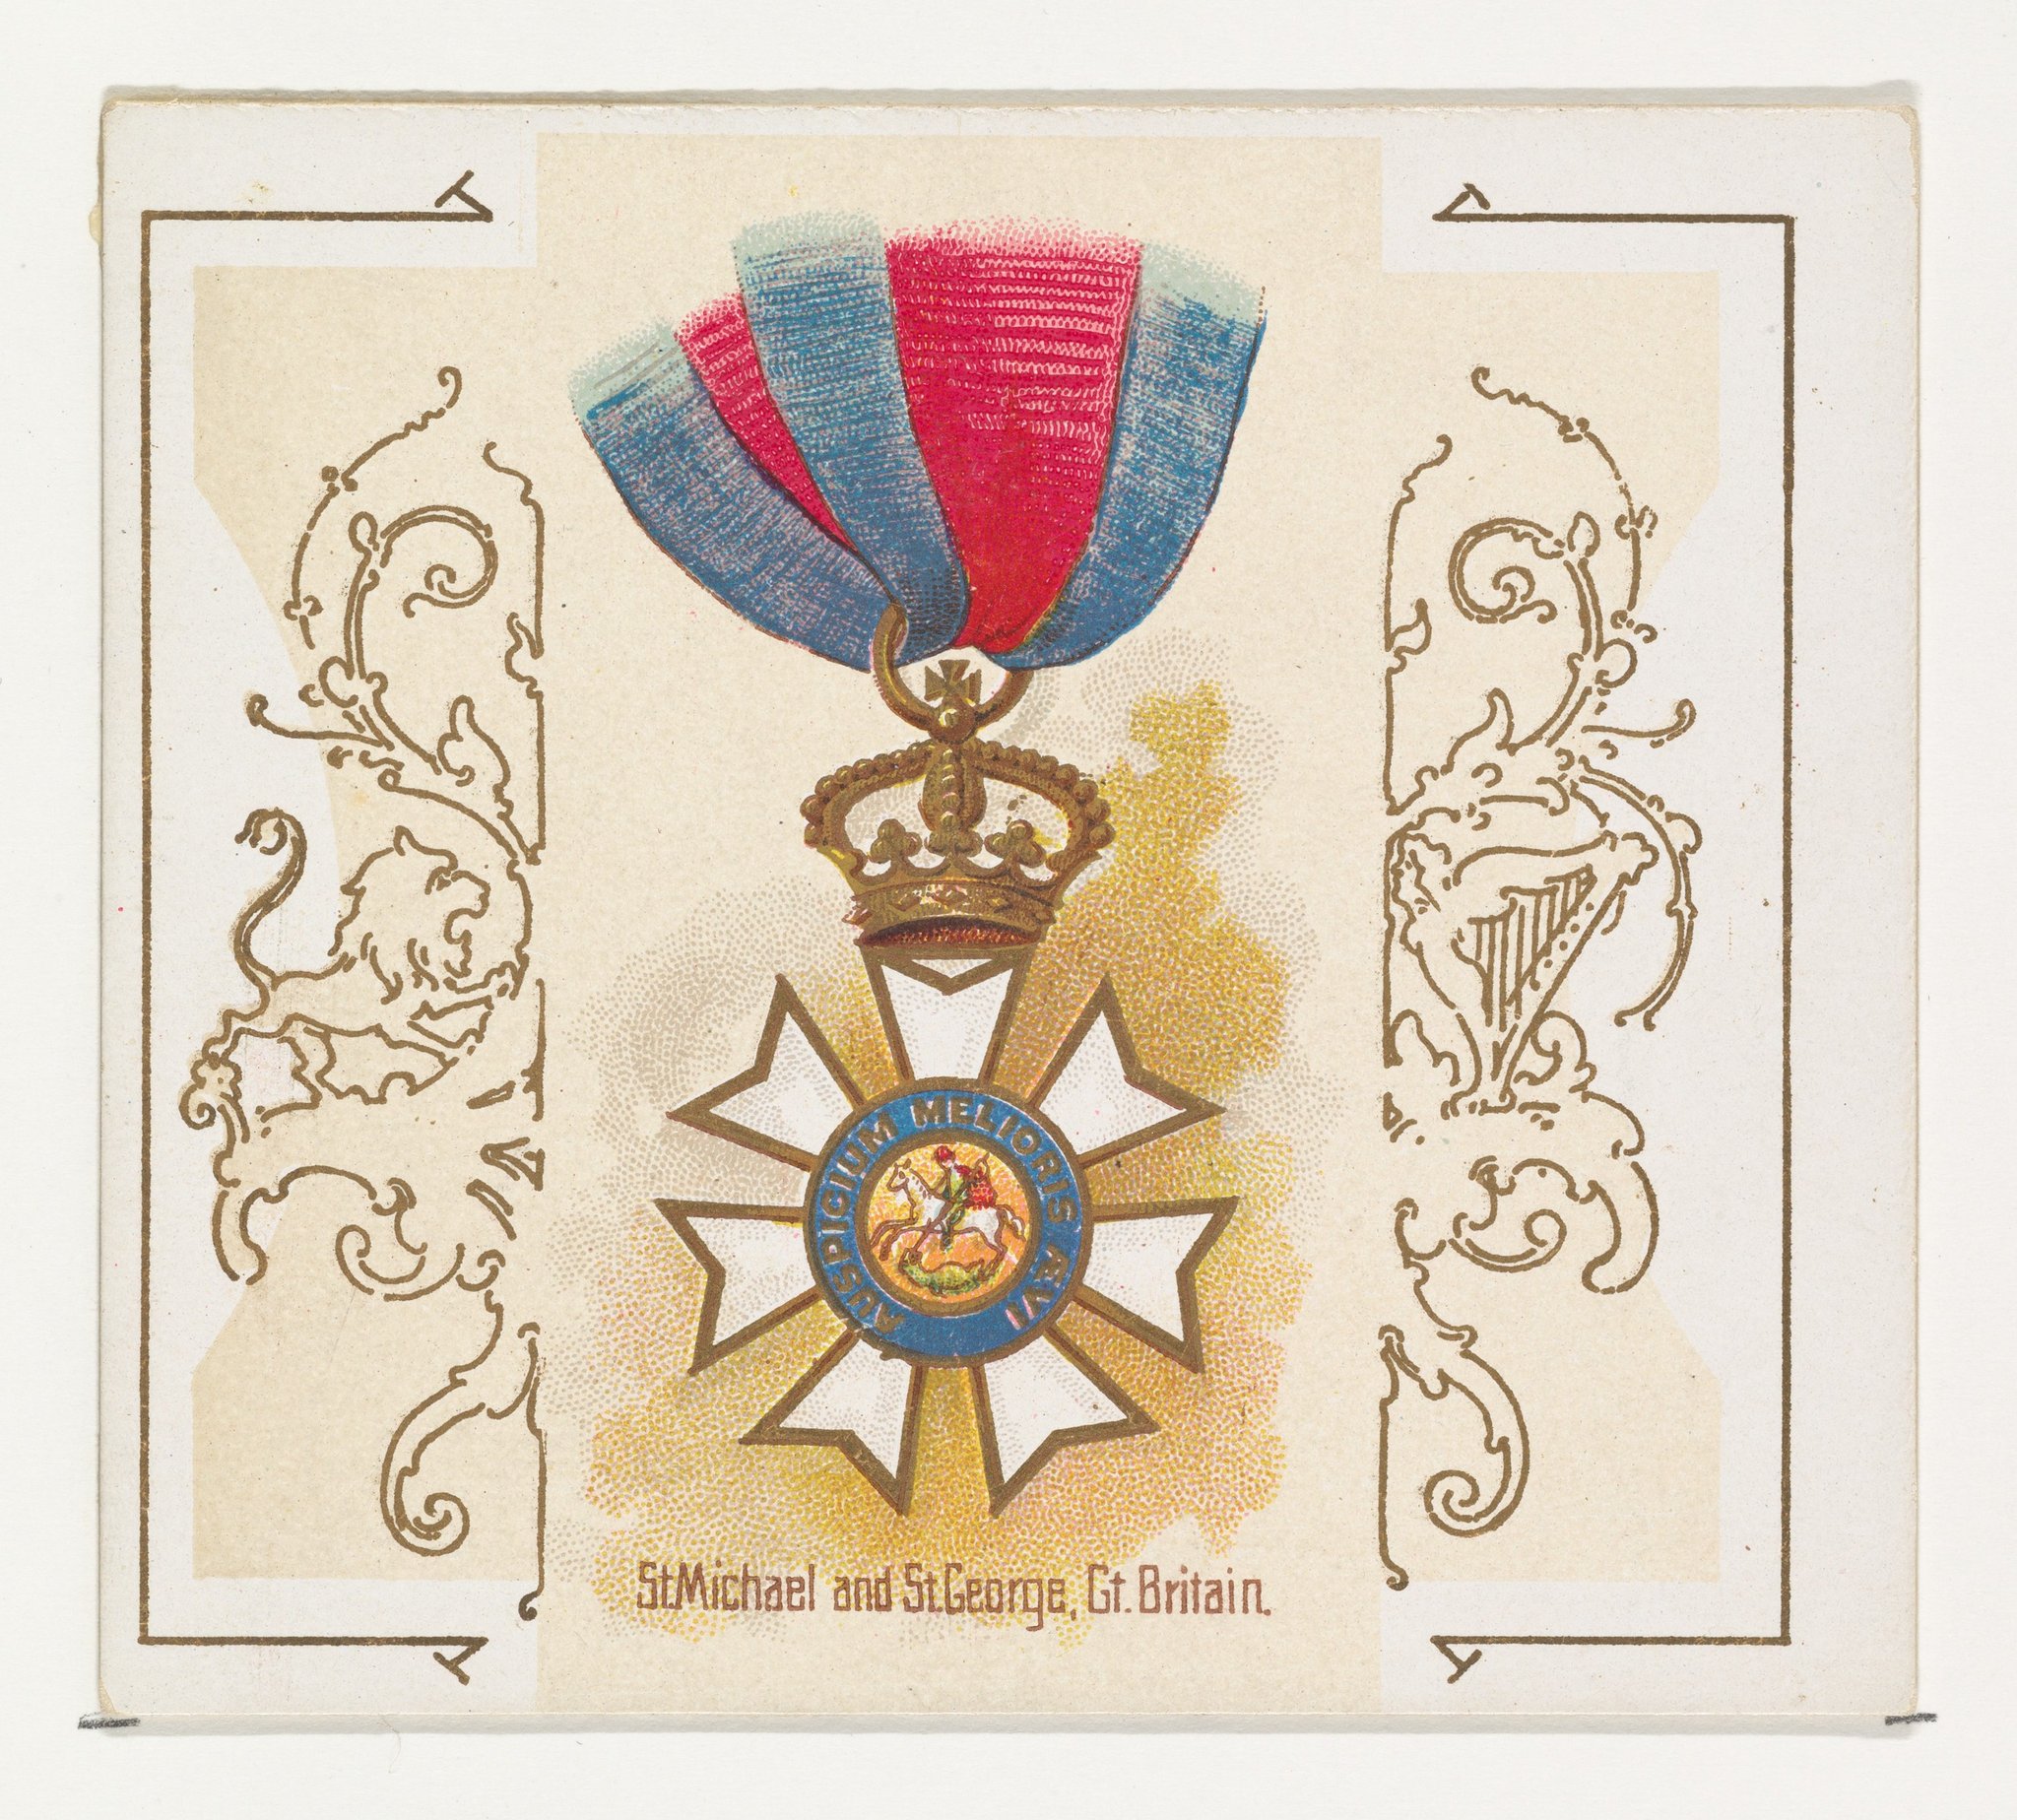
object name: print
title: Saint Michael and Saint George, Great Britain, from the World's Decorations series (N44) for Allen & Ginter Cigarettes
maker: allen & ginter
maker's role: publisher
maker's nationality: american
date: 1890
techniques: color lithograph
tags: medals